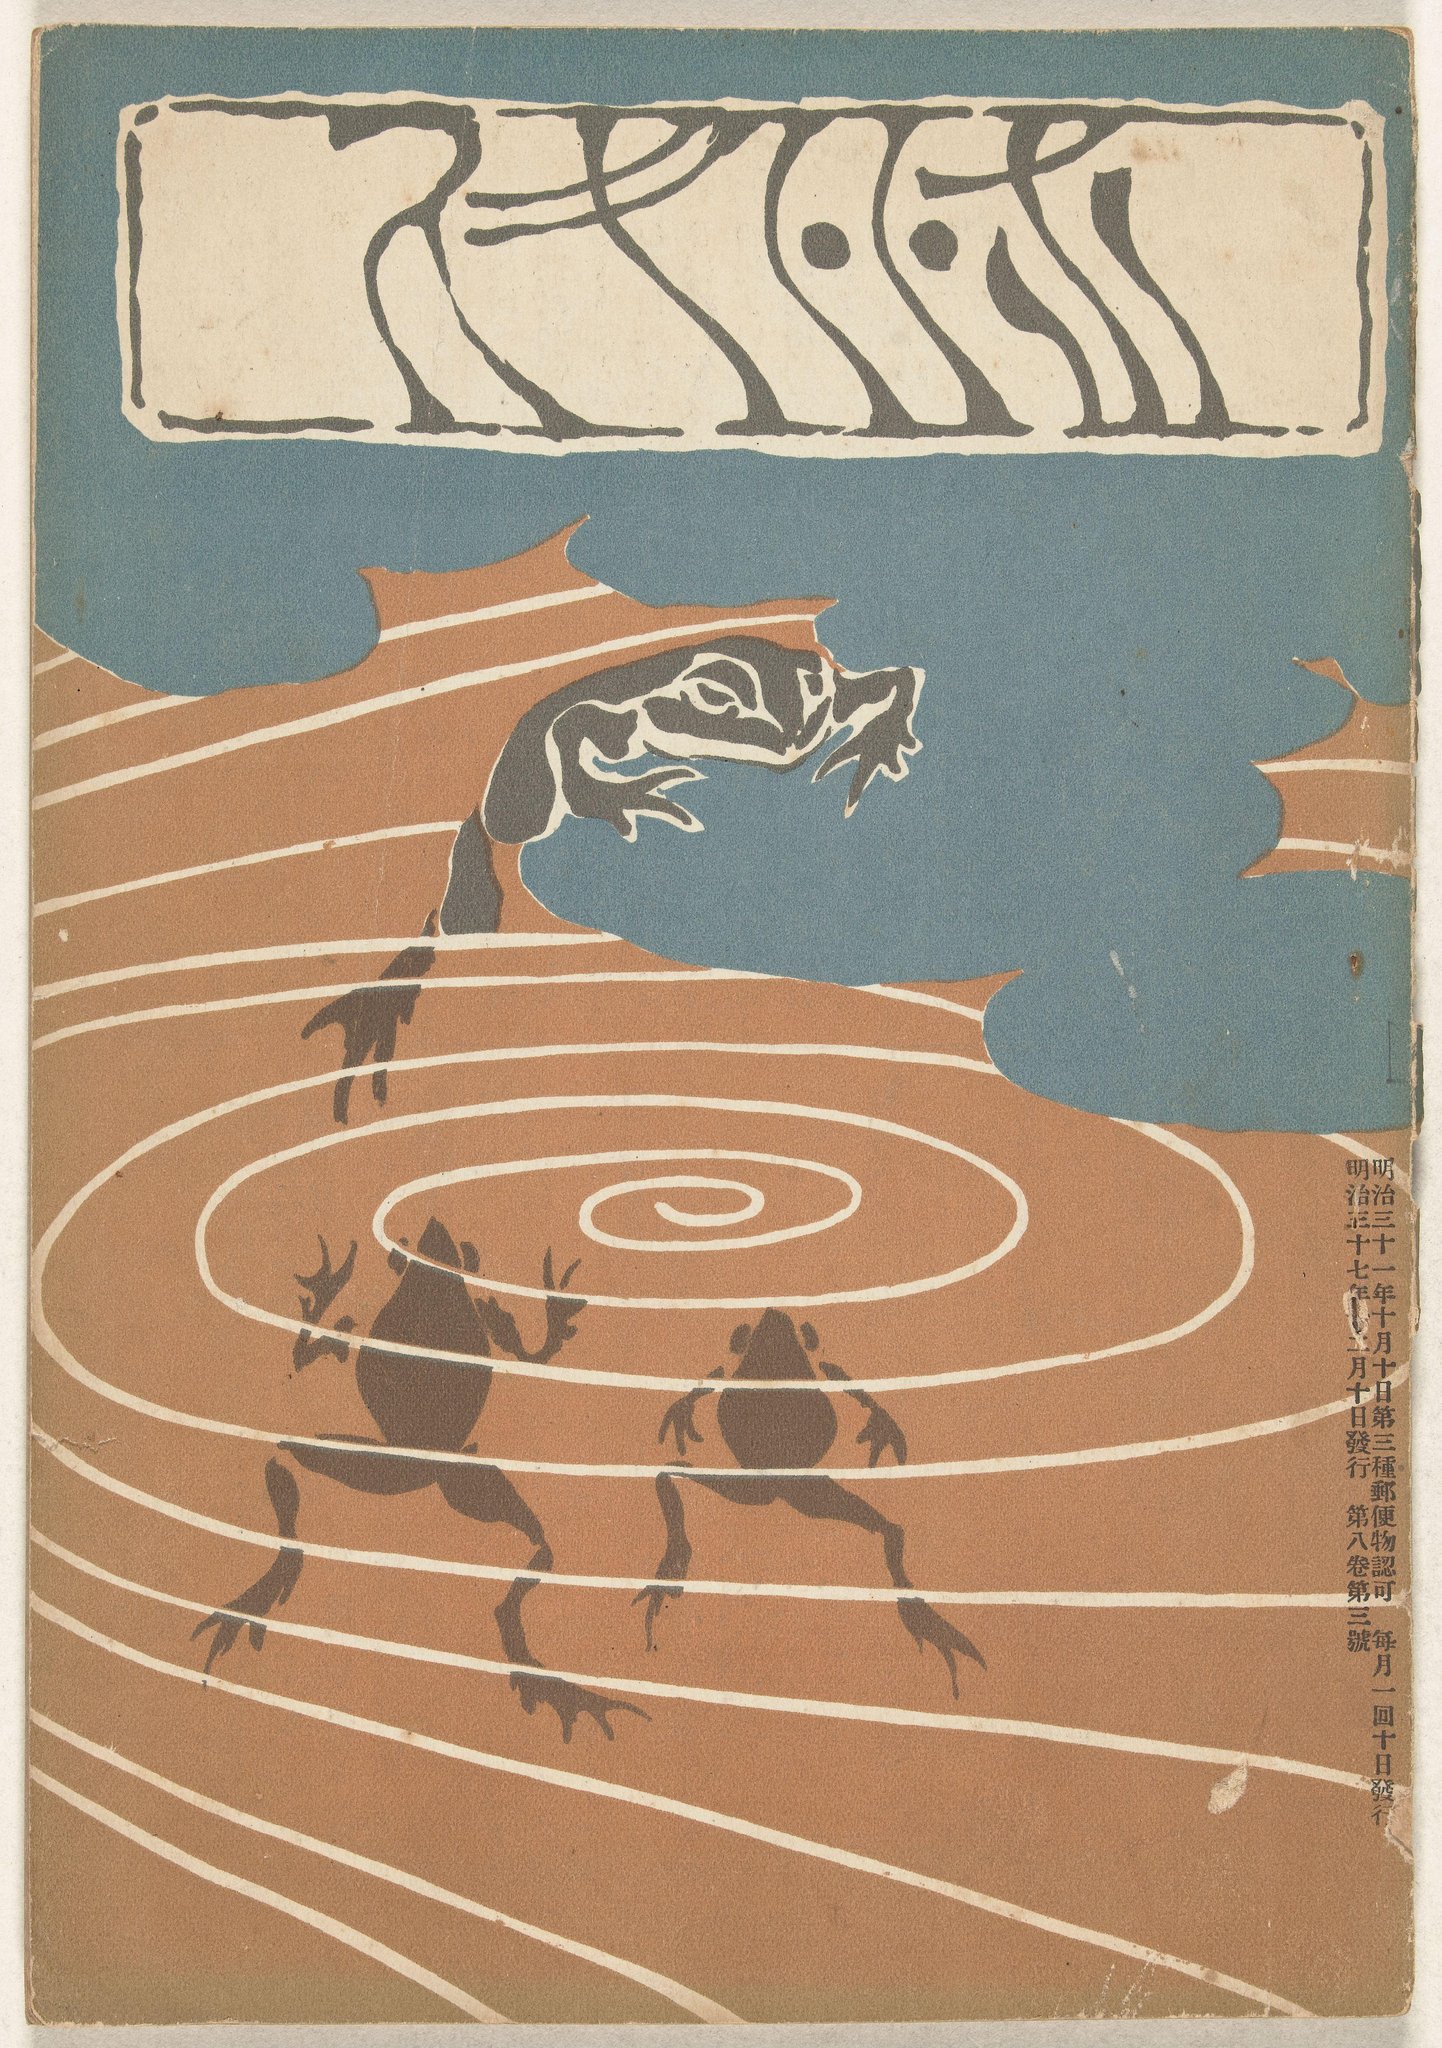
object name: book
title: December 1904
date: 1904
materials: paper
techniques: woodcut, letterpress printing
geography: japan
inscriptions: date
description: Nummer 3 van jaargang 8 (december 1904) van het literaire maandblad Hototogisu: kaft met donkergrijze kikkers in oranjebruin water en blauwe waterleliebladeren; achterkant, afbeelding van twee kinderen een grote sneeuwbal rollend.